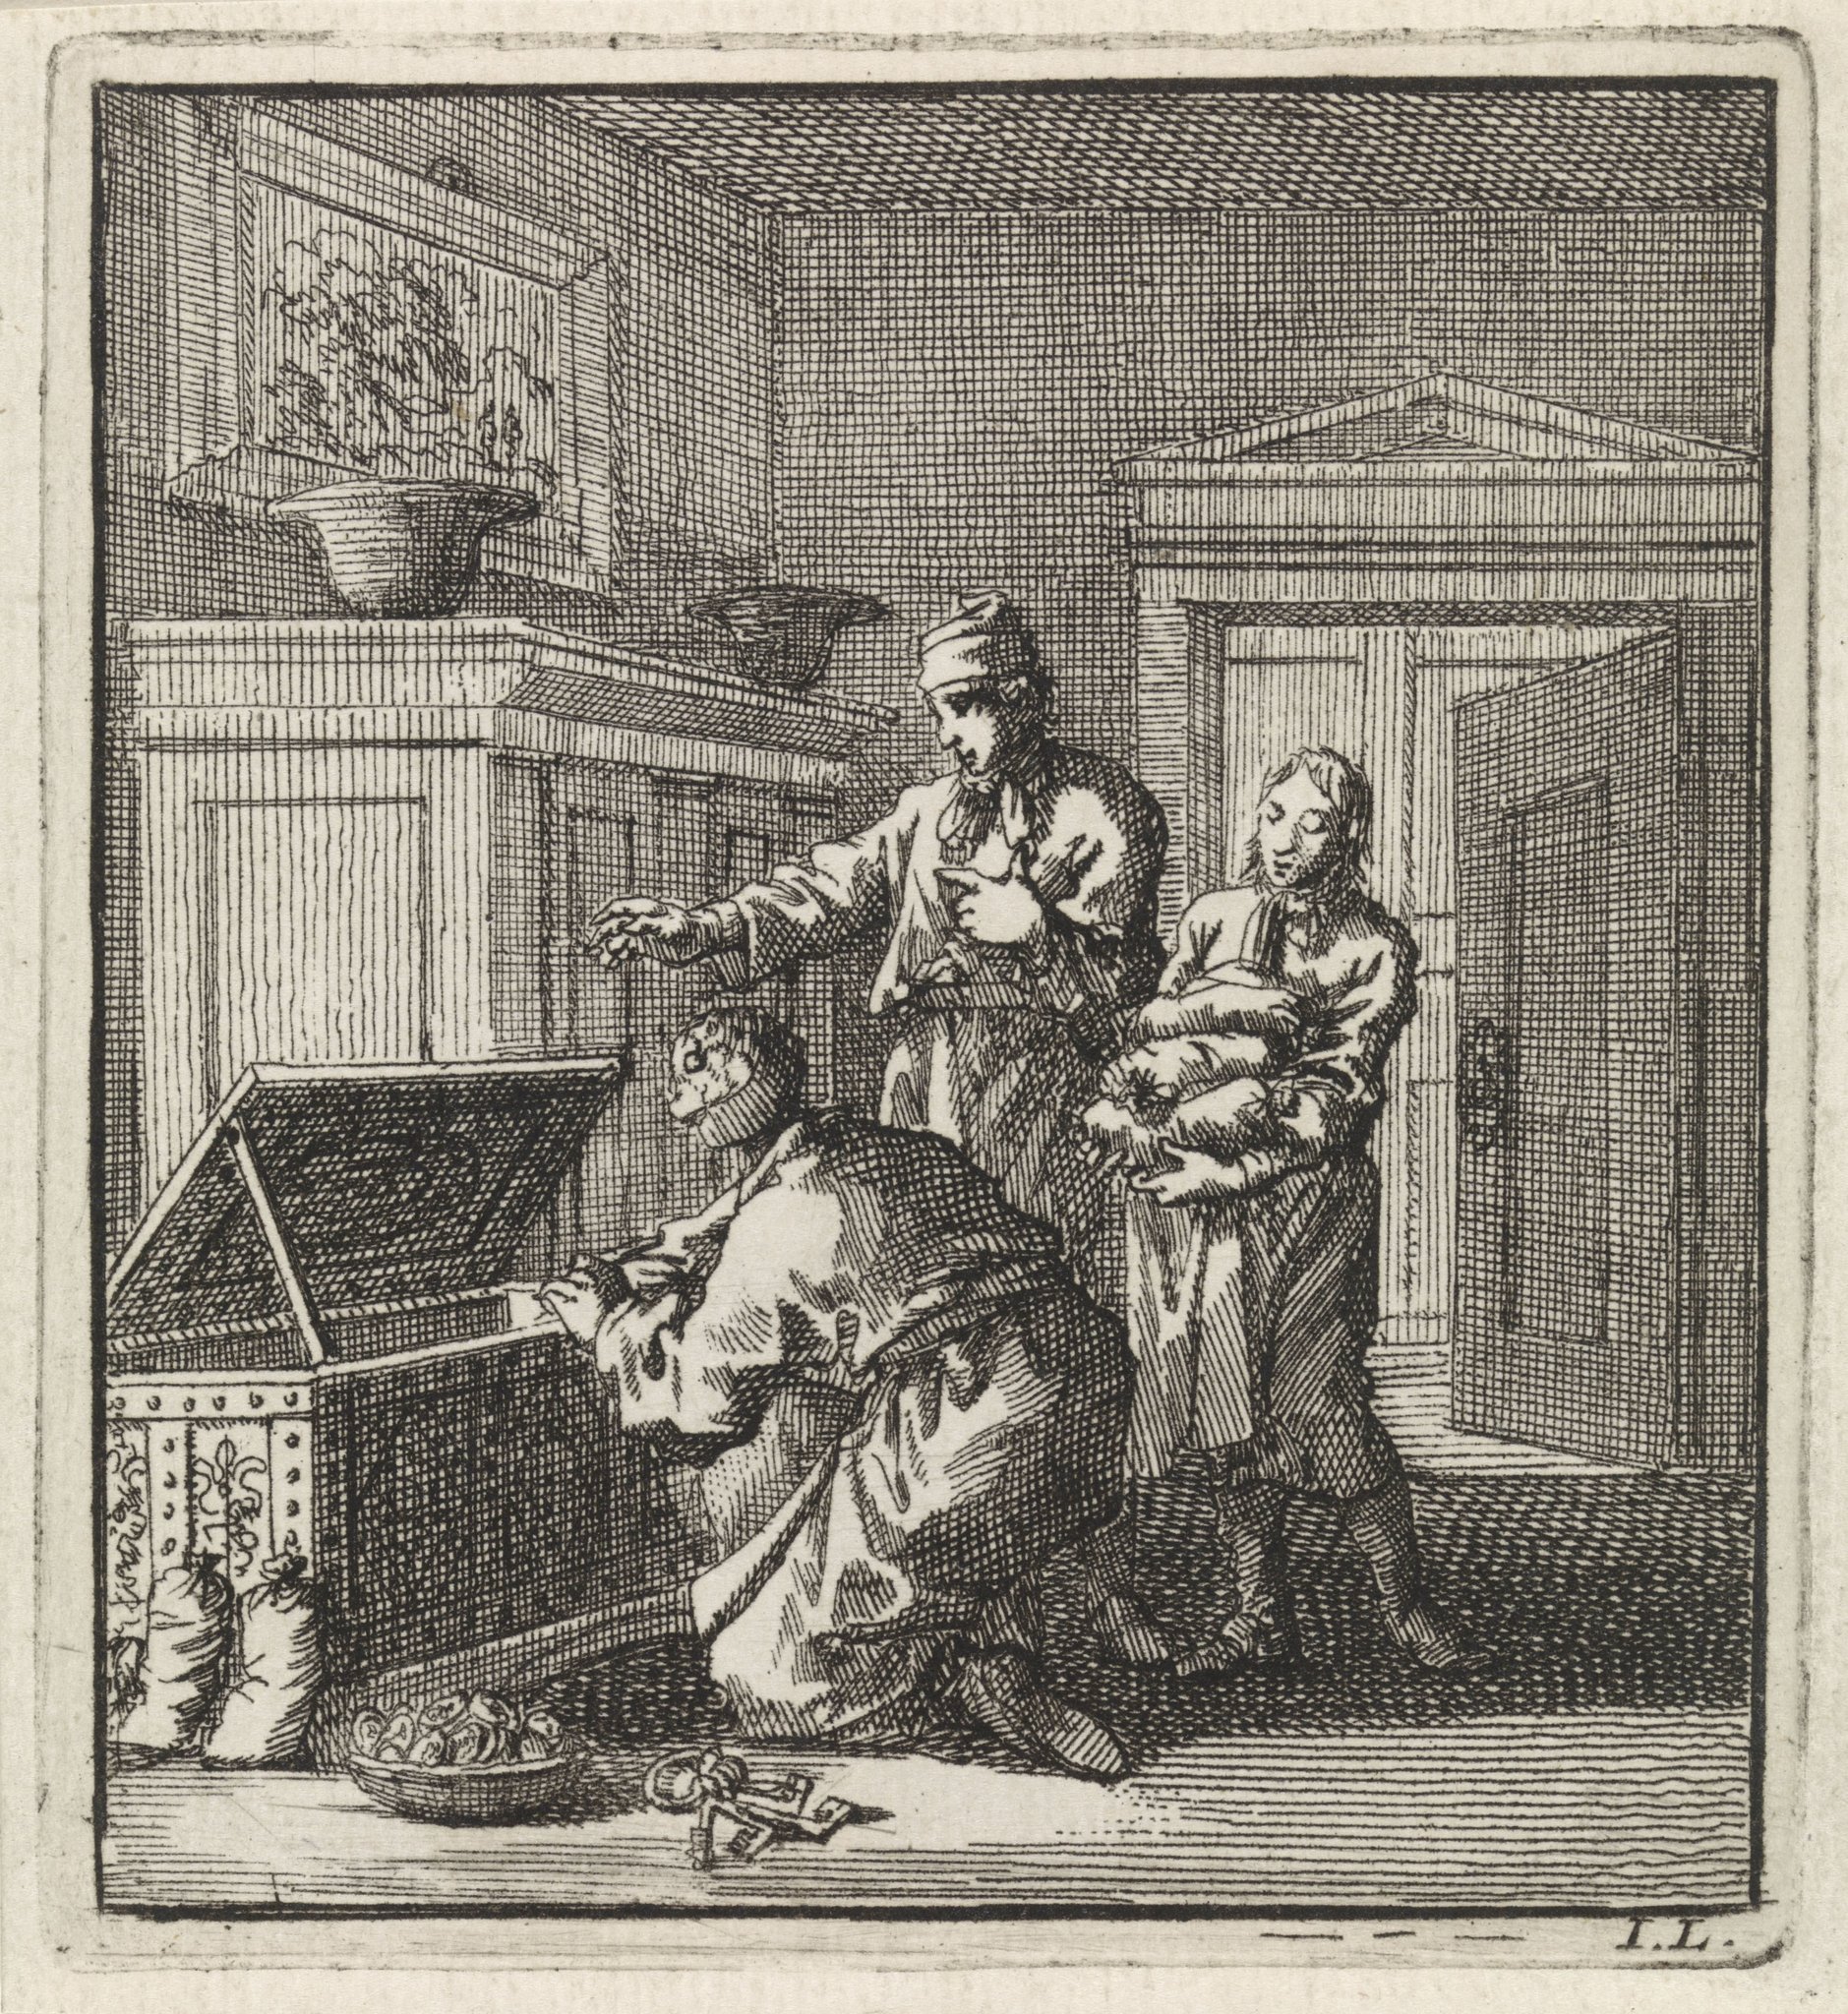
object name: print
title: Drie mannen bij een geldkist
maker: jan luyken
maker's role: draughtsman, print maker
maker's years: 1649-1712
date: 1711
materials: paper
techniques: etching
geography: amsterdam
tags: picture, painting, money-chest, treasure-chest, money-box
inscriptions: collector's mark: Lugt 2228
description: Illustratie voor: Luyken, Jan. Het leerzaam huisraad, vertoond in vyftig konstige figuuren, met godlyke spreuken en stichtelyke verzen: Pieter Arentsz. II (wed.) en Cornelis van der Sys, 1711, p. 26.